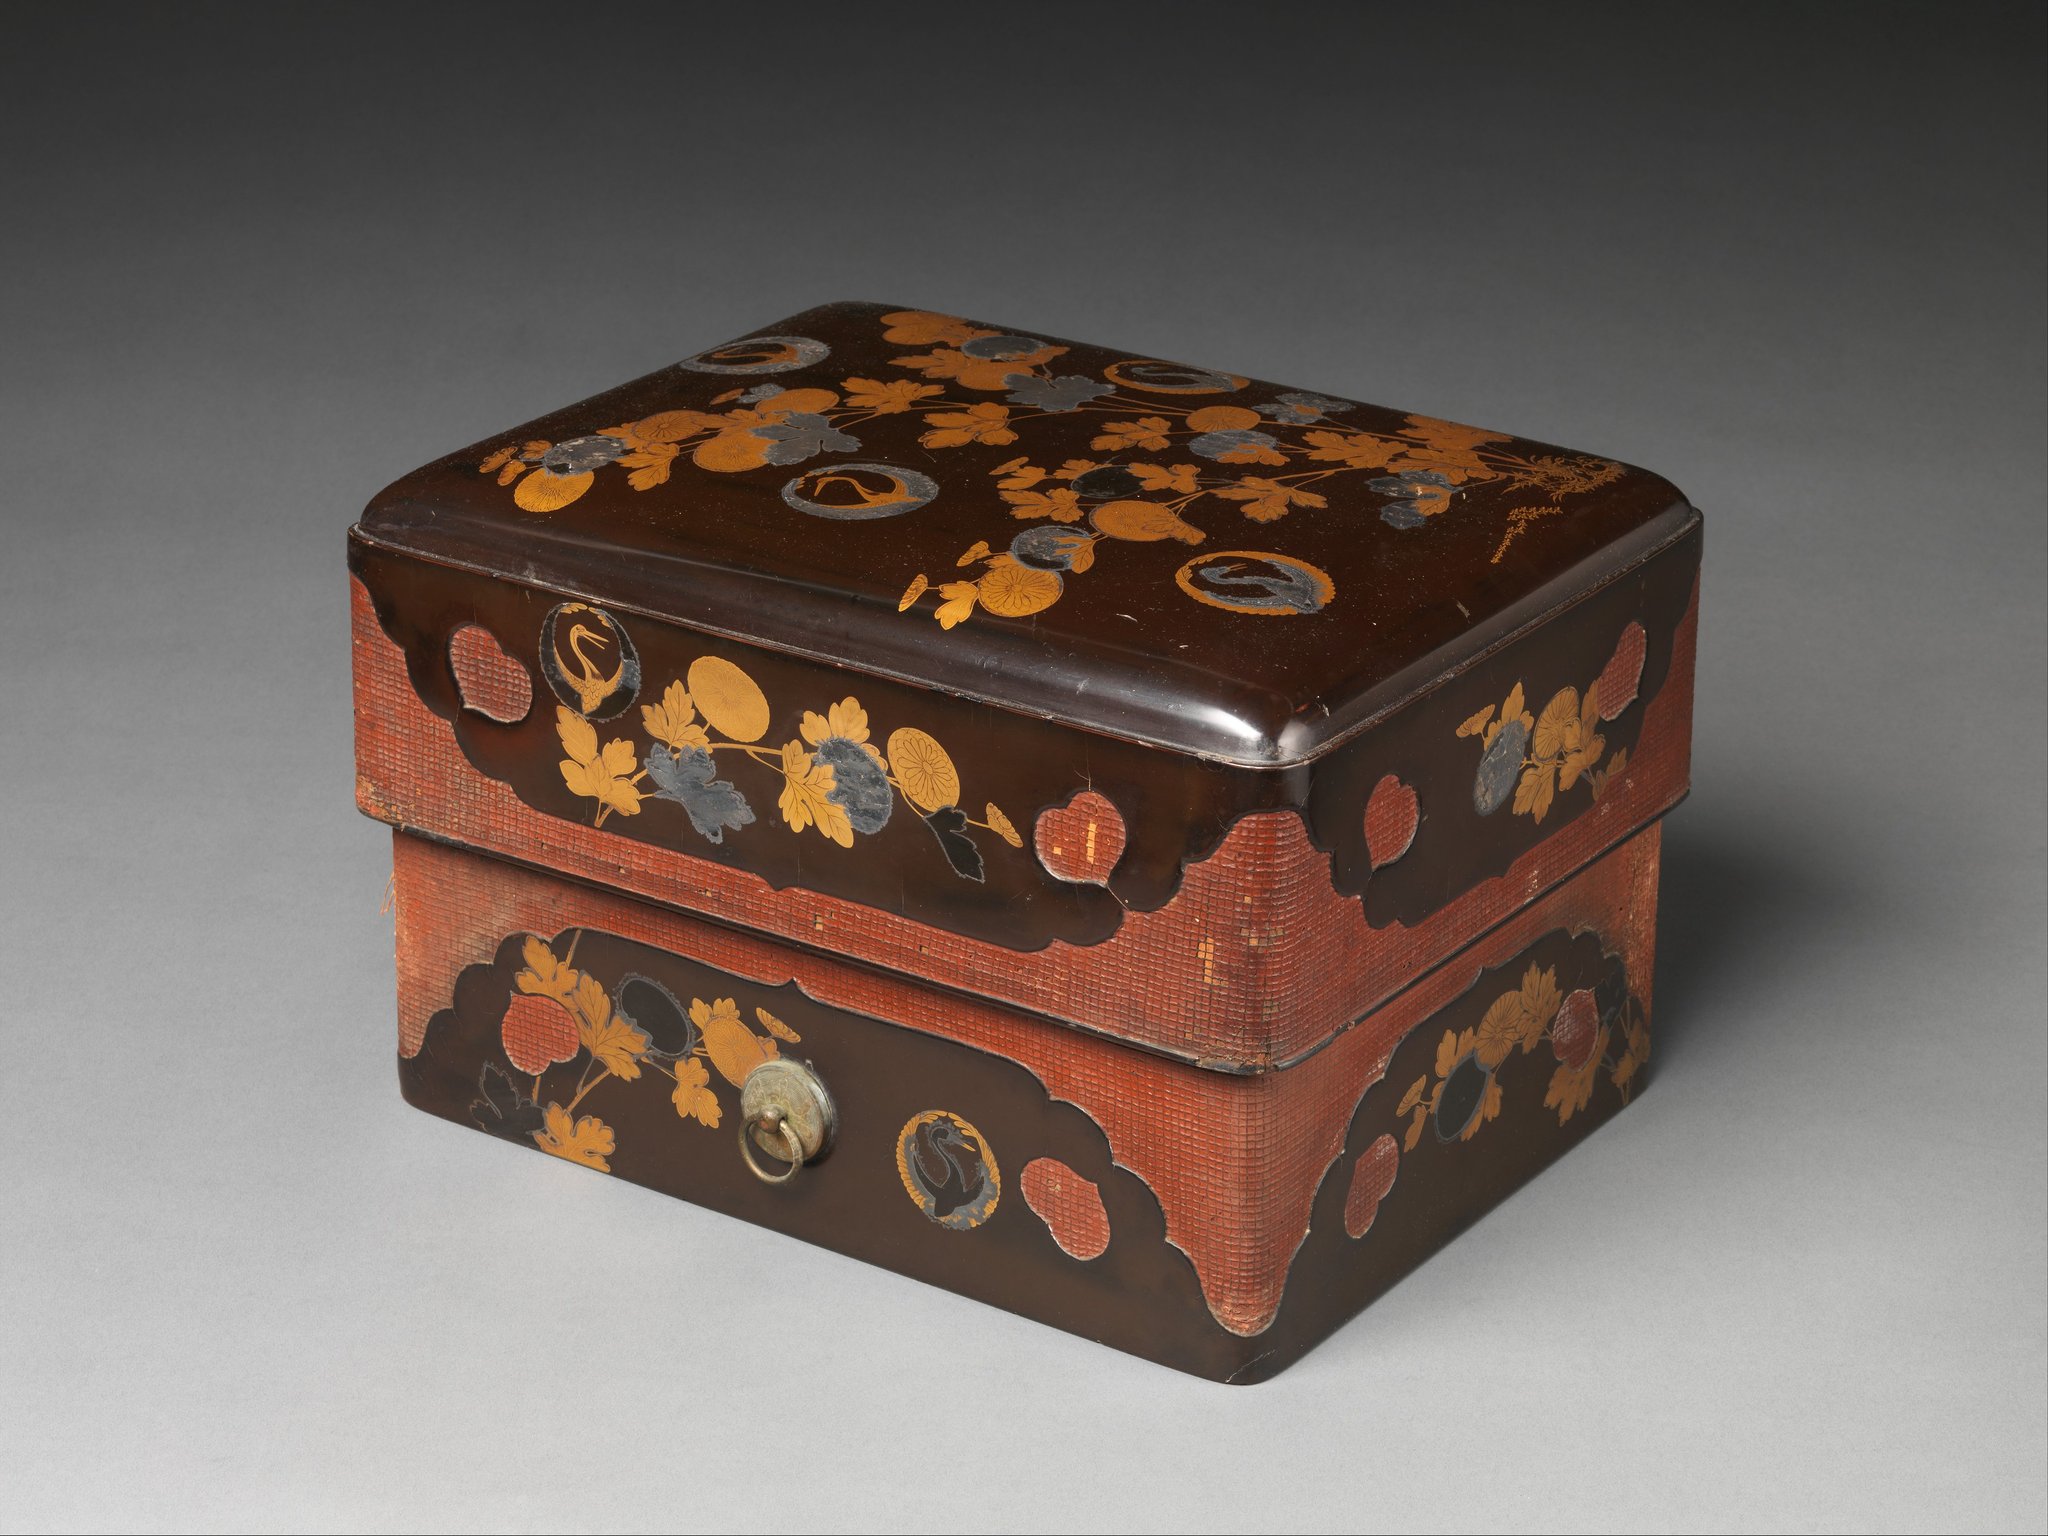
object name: box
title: Red-Cornered Box (Sumiaka)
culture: japanese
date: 1601-1633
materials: textile, foil, gold, lacquer, silver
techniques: inlay, maki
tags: leaves